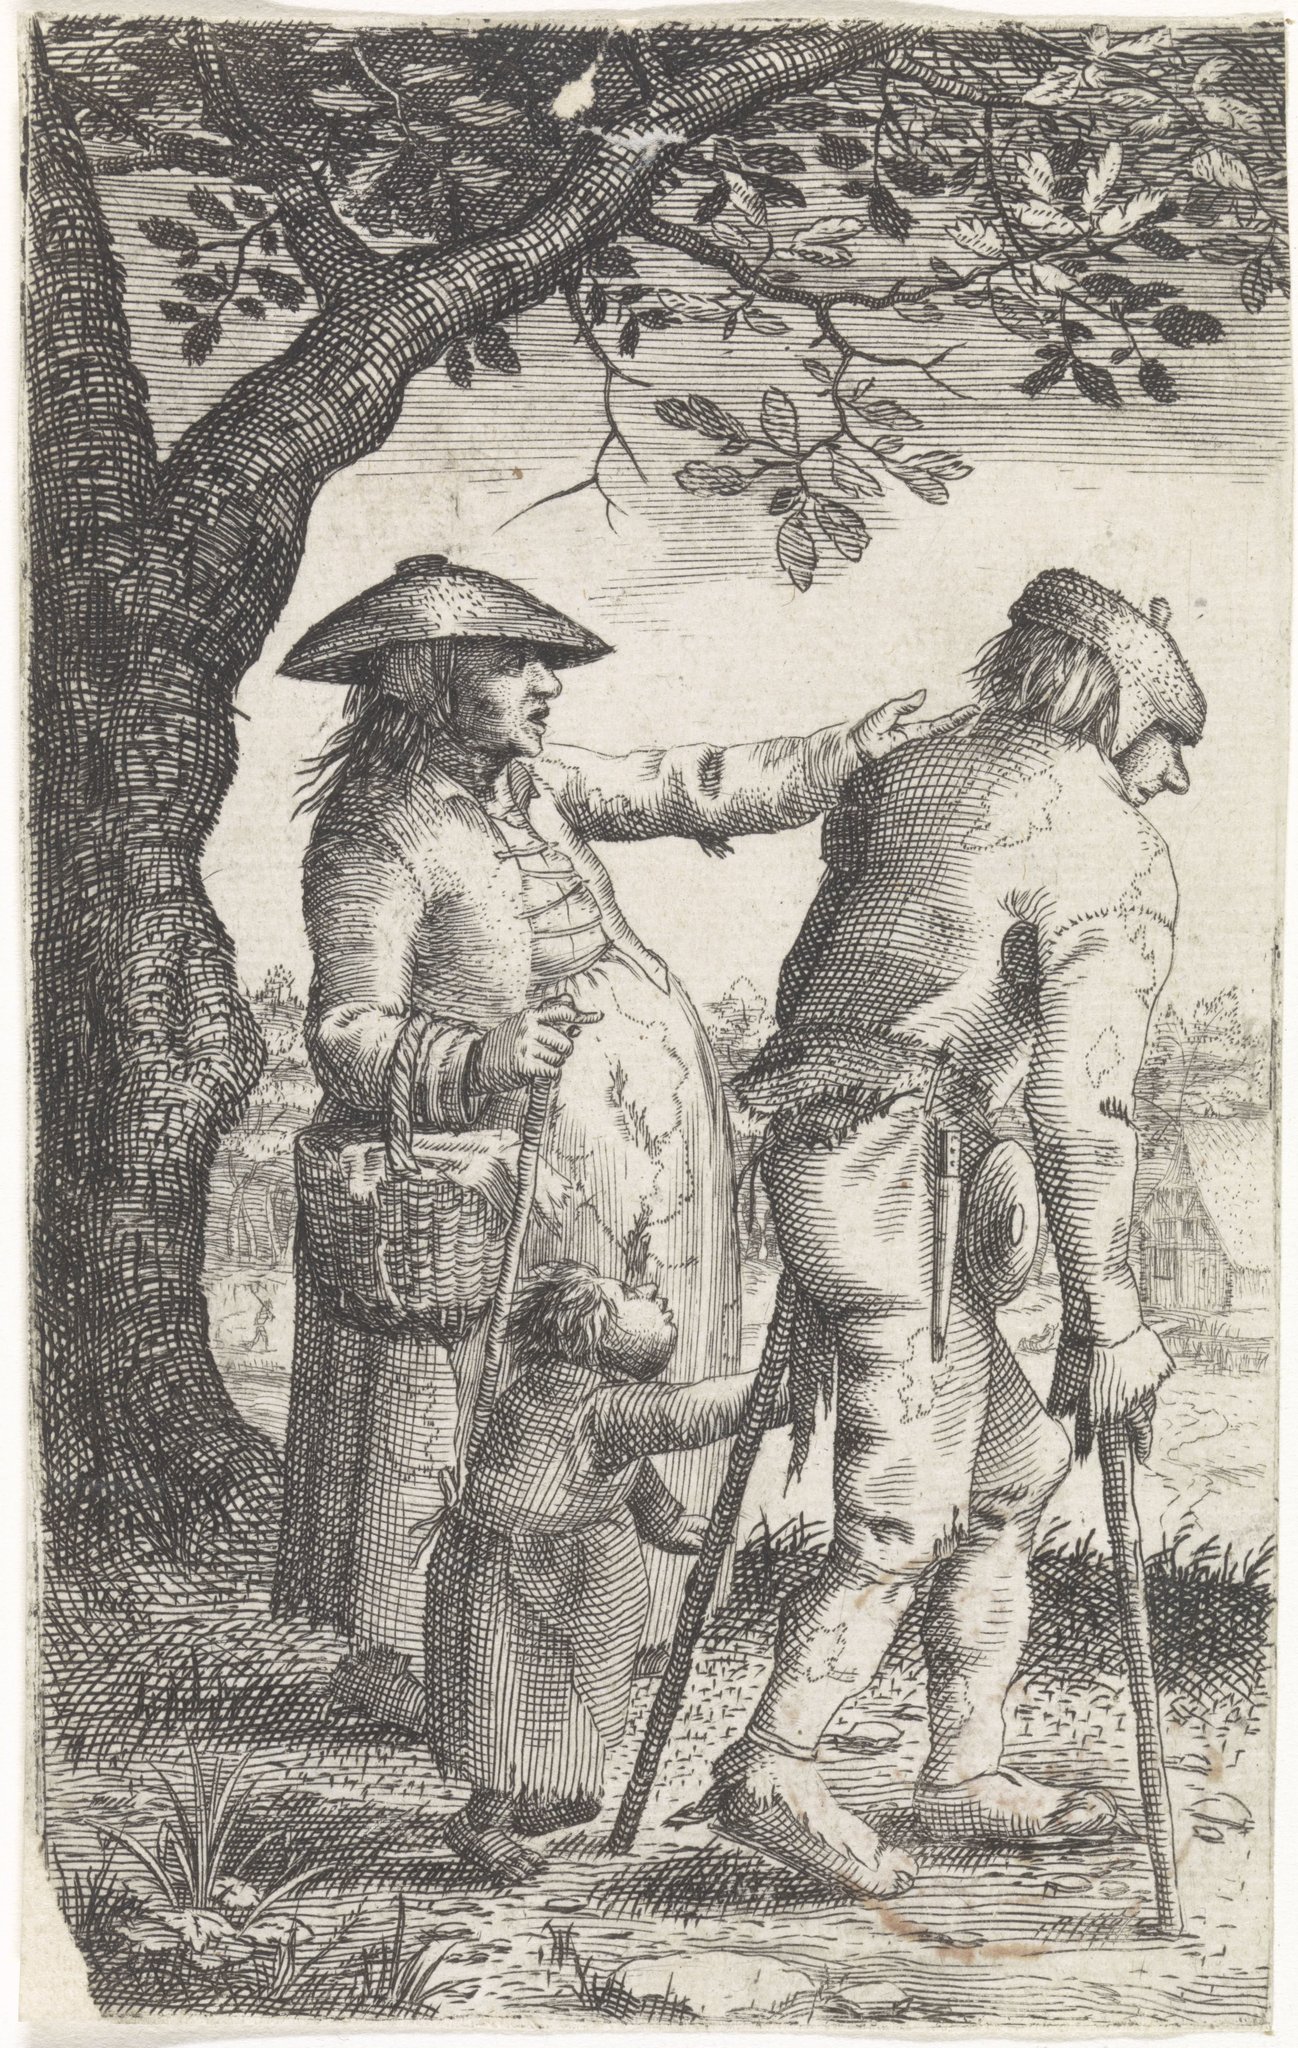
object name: print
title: Bedelaars op krukken bij een vrouw en een kind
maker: Anonymous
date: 1608-1612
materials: paper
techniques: engraving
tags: crutches, carrying something in basket, bag, rucksack, etc., mother and baby or young child, beggar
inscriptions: collector's mark: Lugt 240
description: Een man op krukken bij een vrouw die de linkerhand uitstrekt. De vrouw heeft een mand aan de rechterarm en een stok in de rechterhand. Tussen hen in staat een kind dat de rechterarm uitsterkt.